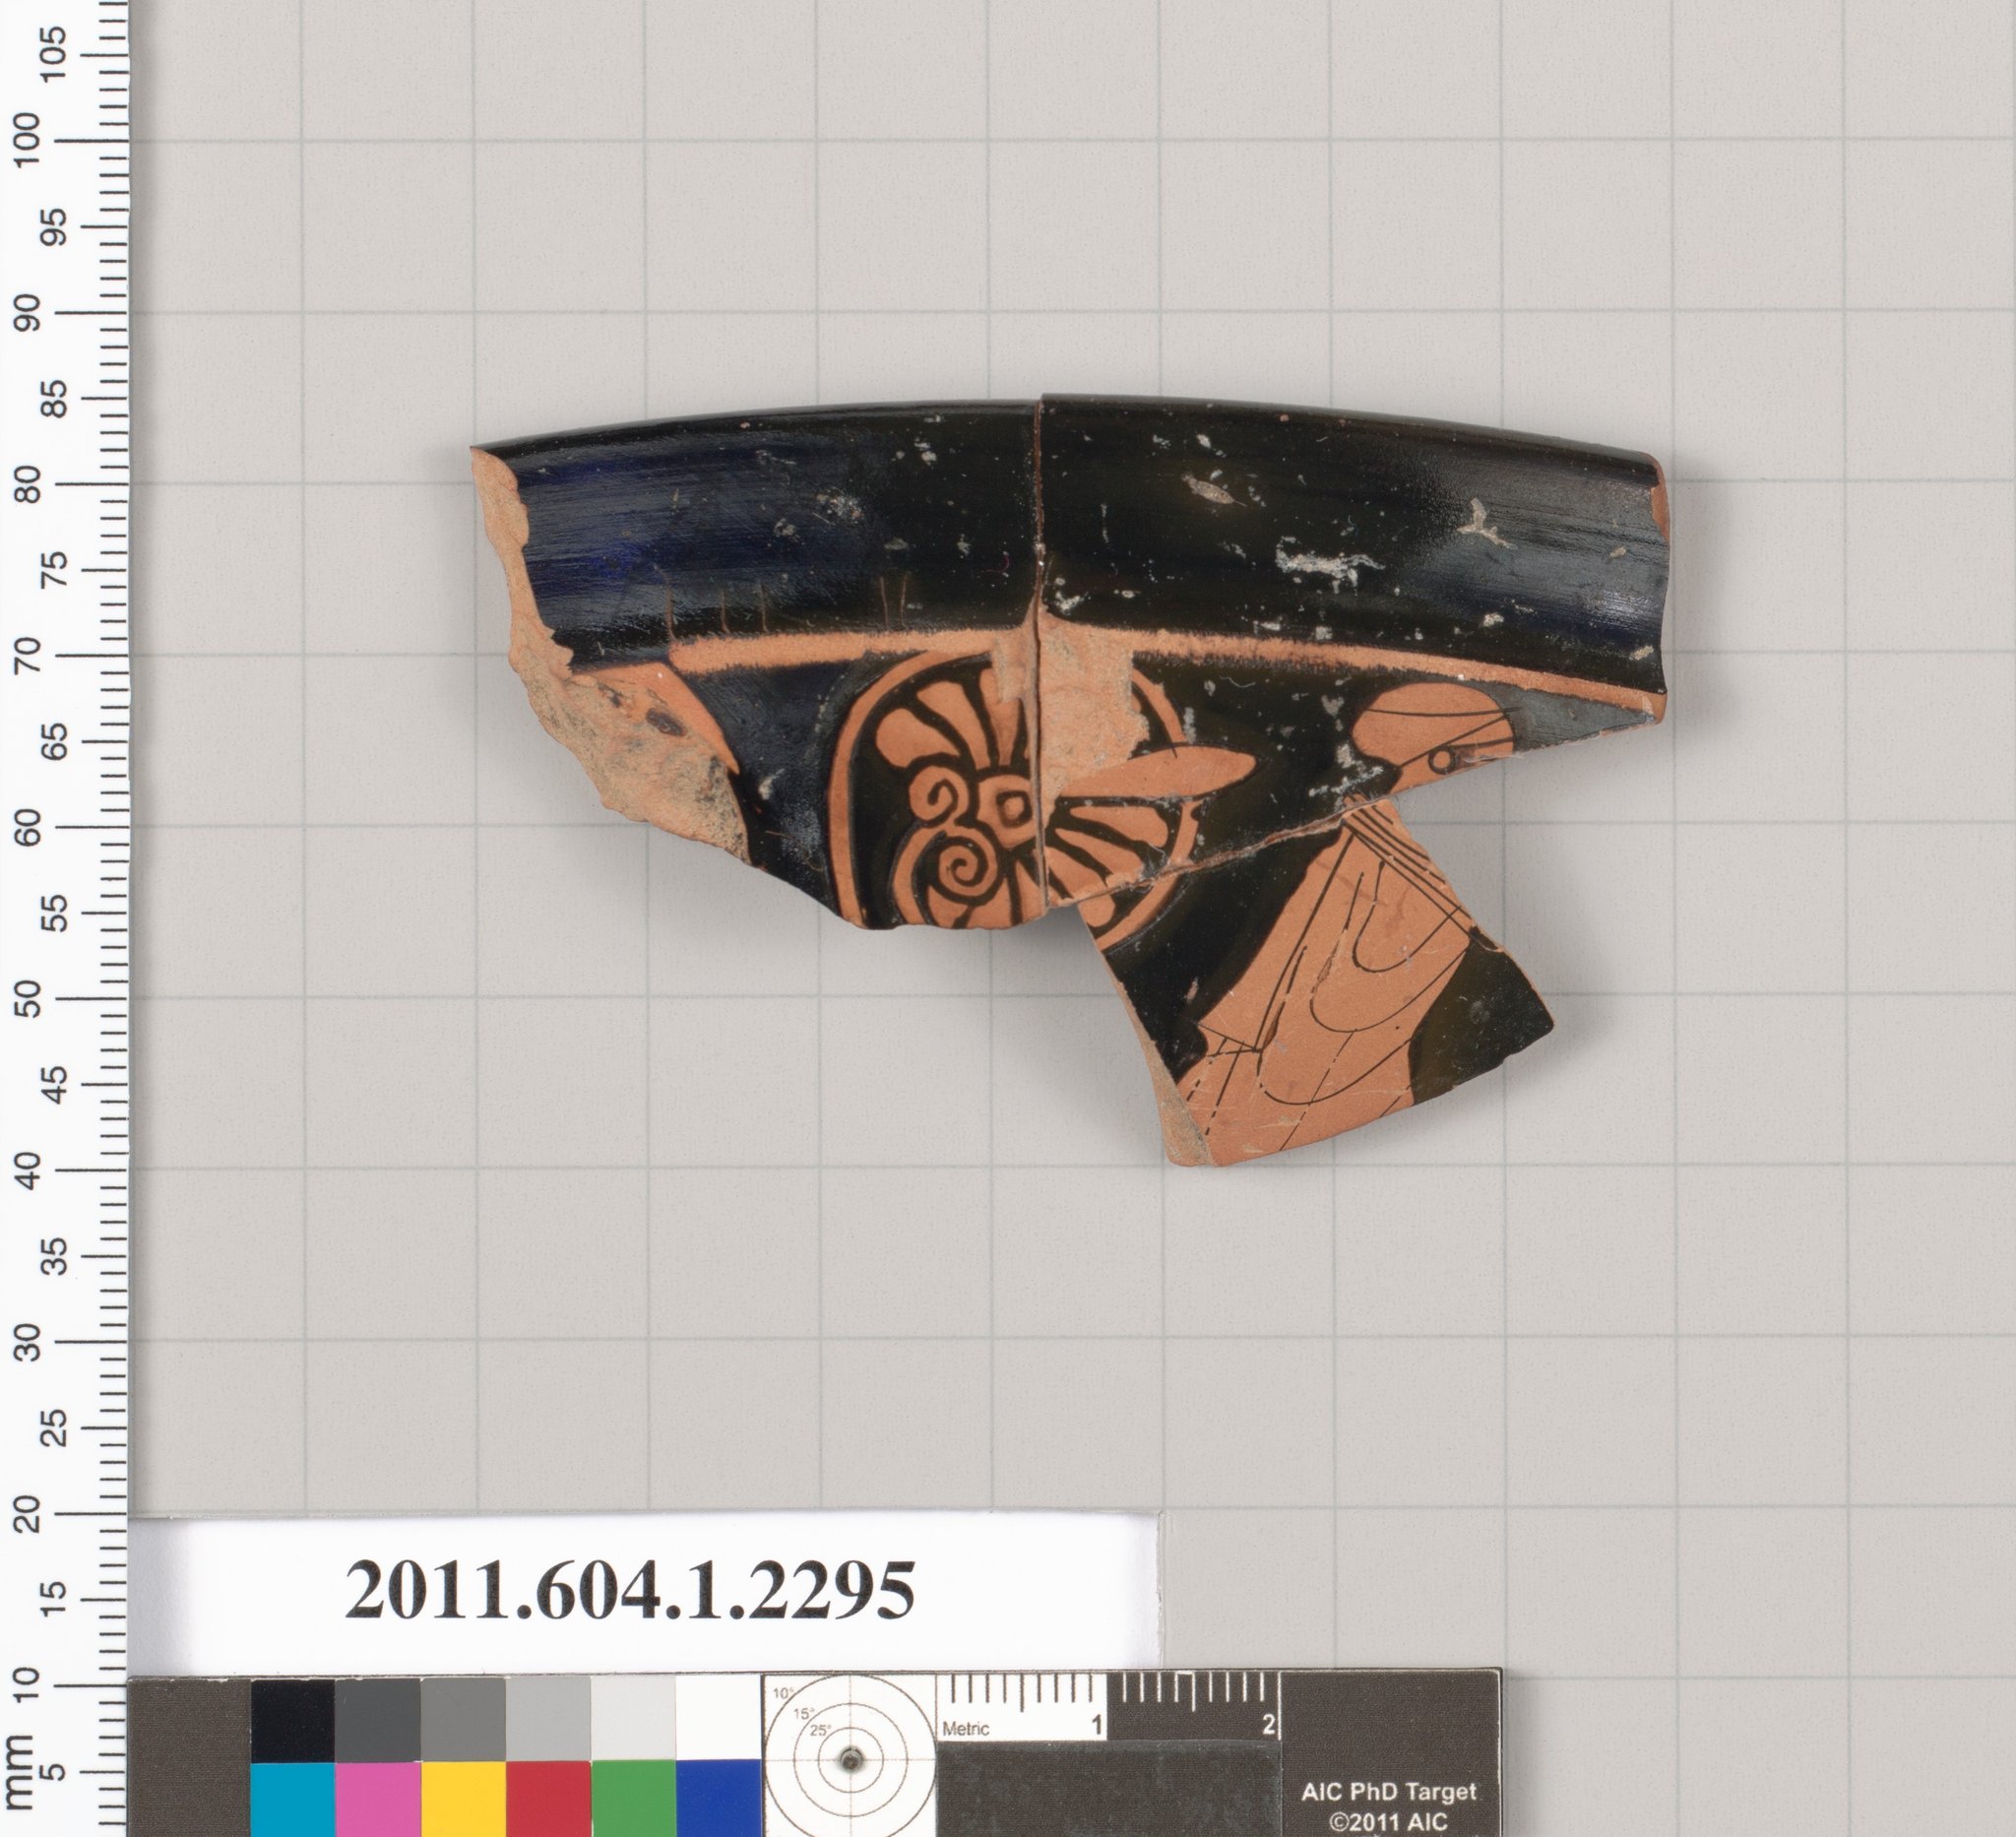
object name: kylix fragment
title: Terracotta rim fragment of a kylix (drinking cup)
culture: greek, attic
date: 475-451 BCE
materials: terracotta